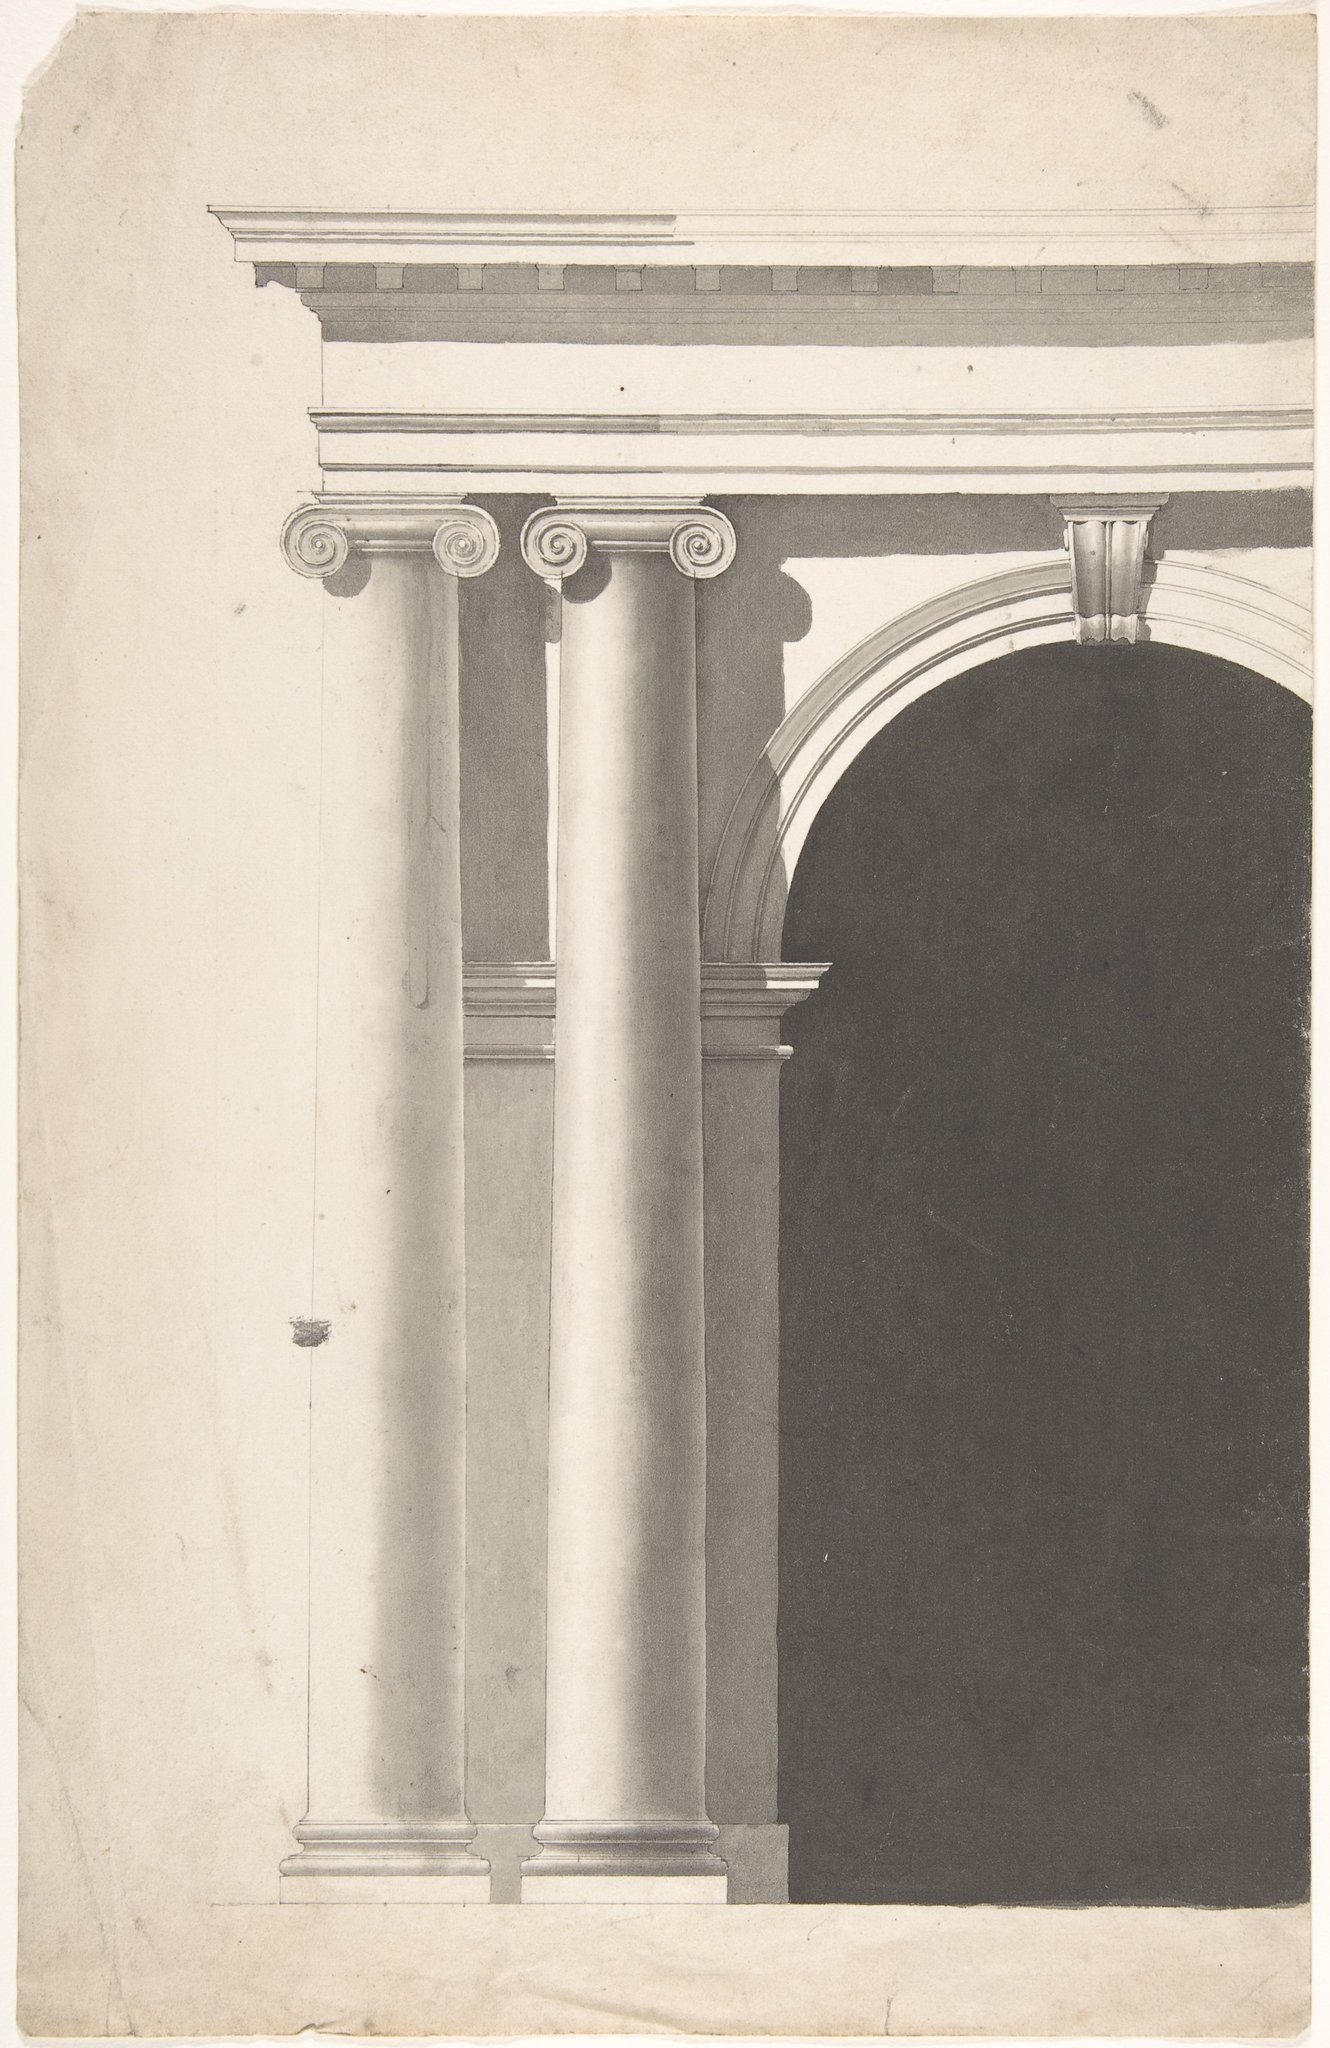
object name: drawing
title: Architectural Portal with Paired Planking Ionic Columns (only left-hand columns and part of arched opening shown)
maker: anonymous, british, late 18th–early 19th century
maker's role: artist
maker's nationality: british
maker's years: 1771-1835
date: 1767-1866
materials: ink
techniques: brush, pen, wash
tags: architecture,columns